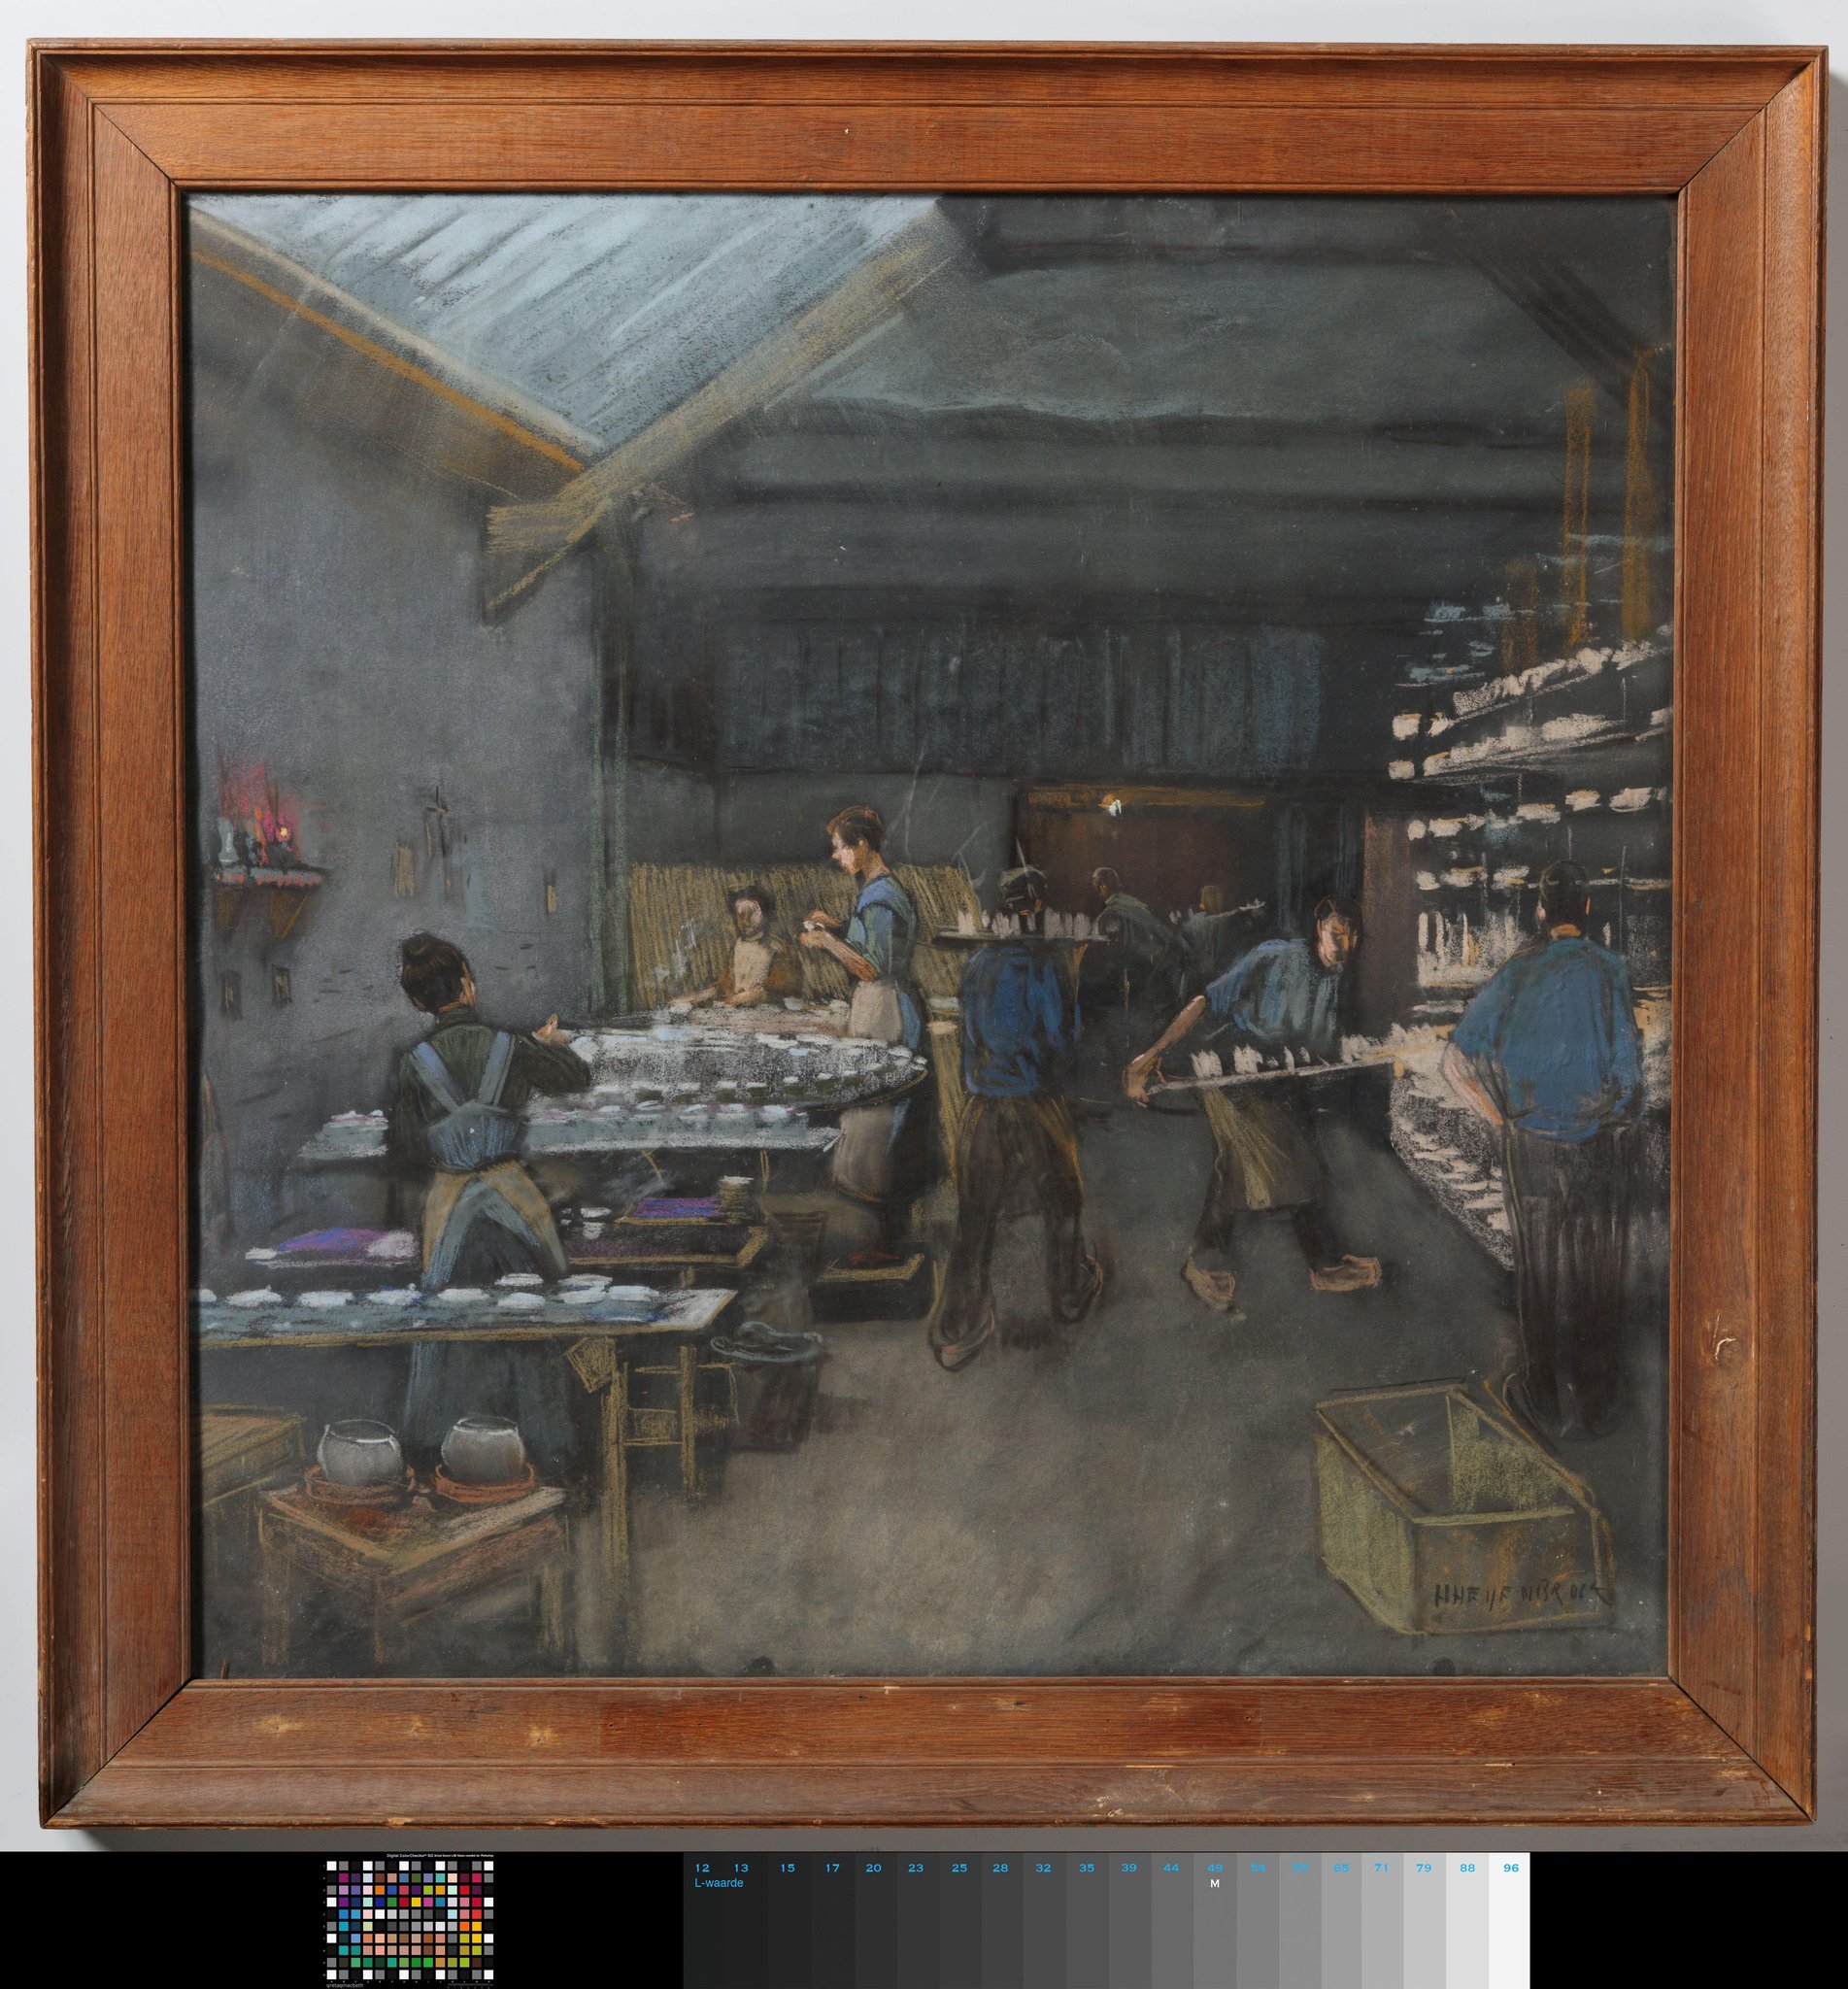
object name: drawing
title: De oude aardewerkfabriek 'Regout' te Maastricht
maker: herman heijenbrock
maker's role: draughtsman, painter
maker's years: 1871-1948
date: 1900-1930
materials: glass, paper, pastel, wood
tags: maastricht